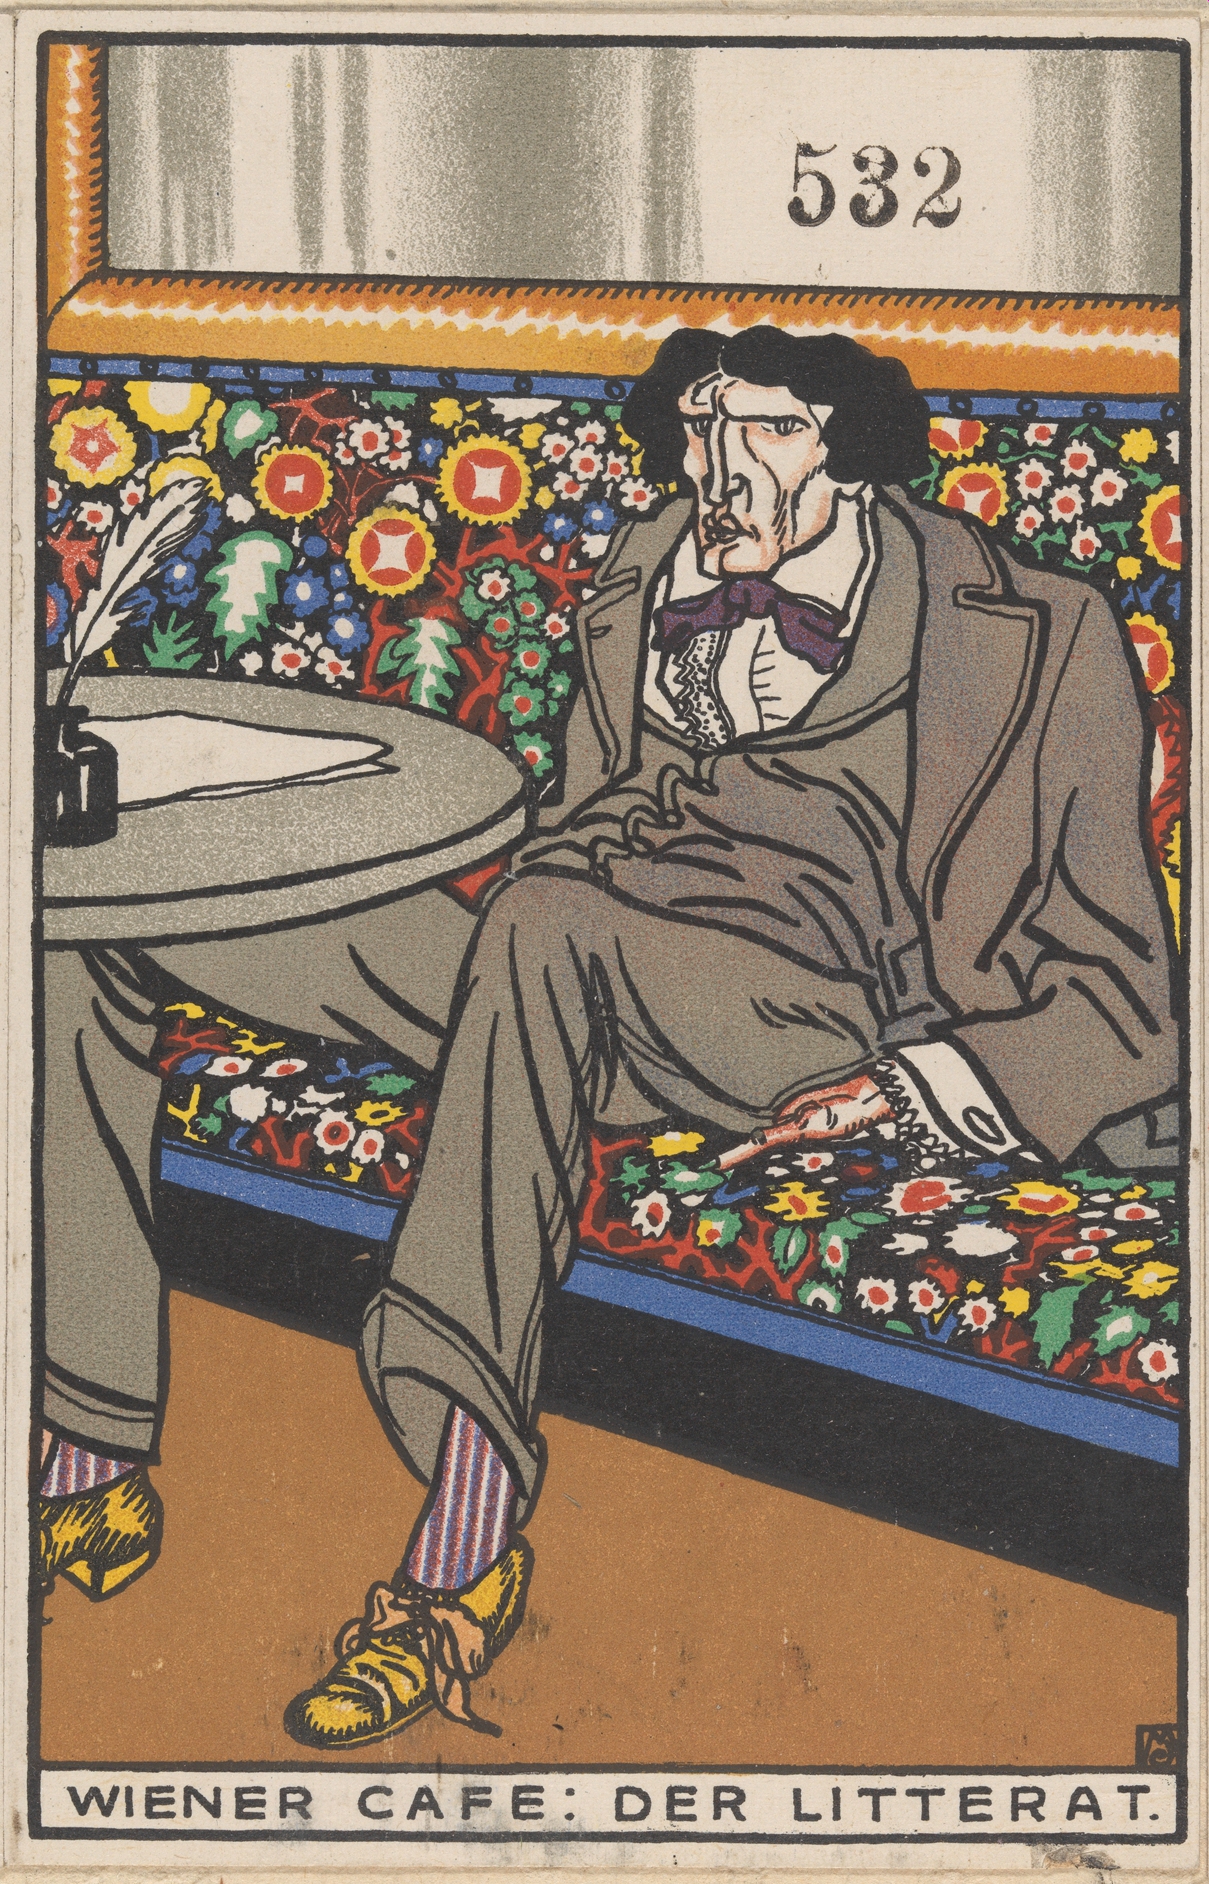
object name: print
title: Viennese Café: The Man of Letters (Wiener Café: Der Litterat)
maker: moriz jung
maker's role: artist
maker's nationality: austrian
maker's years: 1885-1915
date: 1911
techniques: lithograph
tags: men